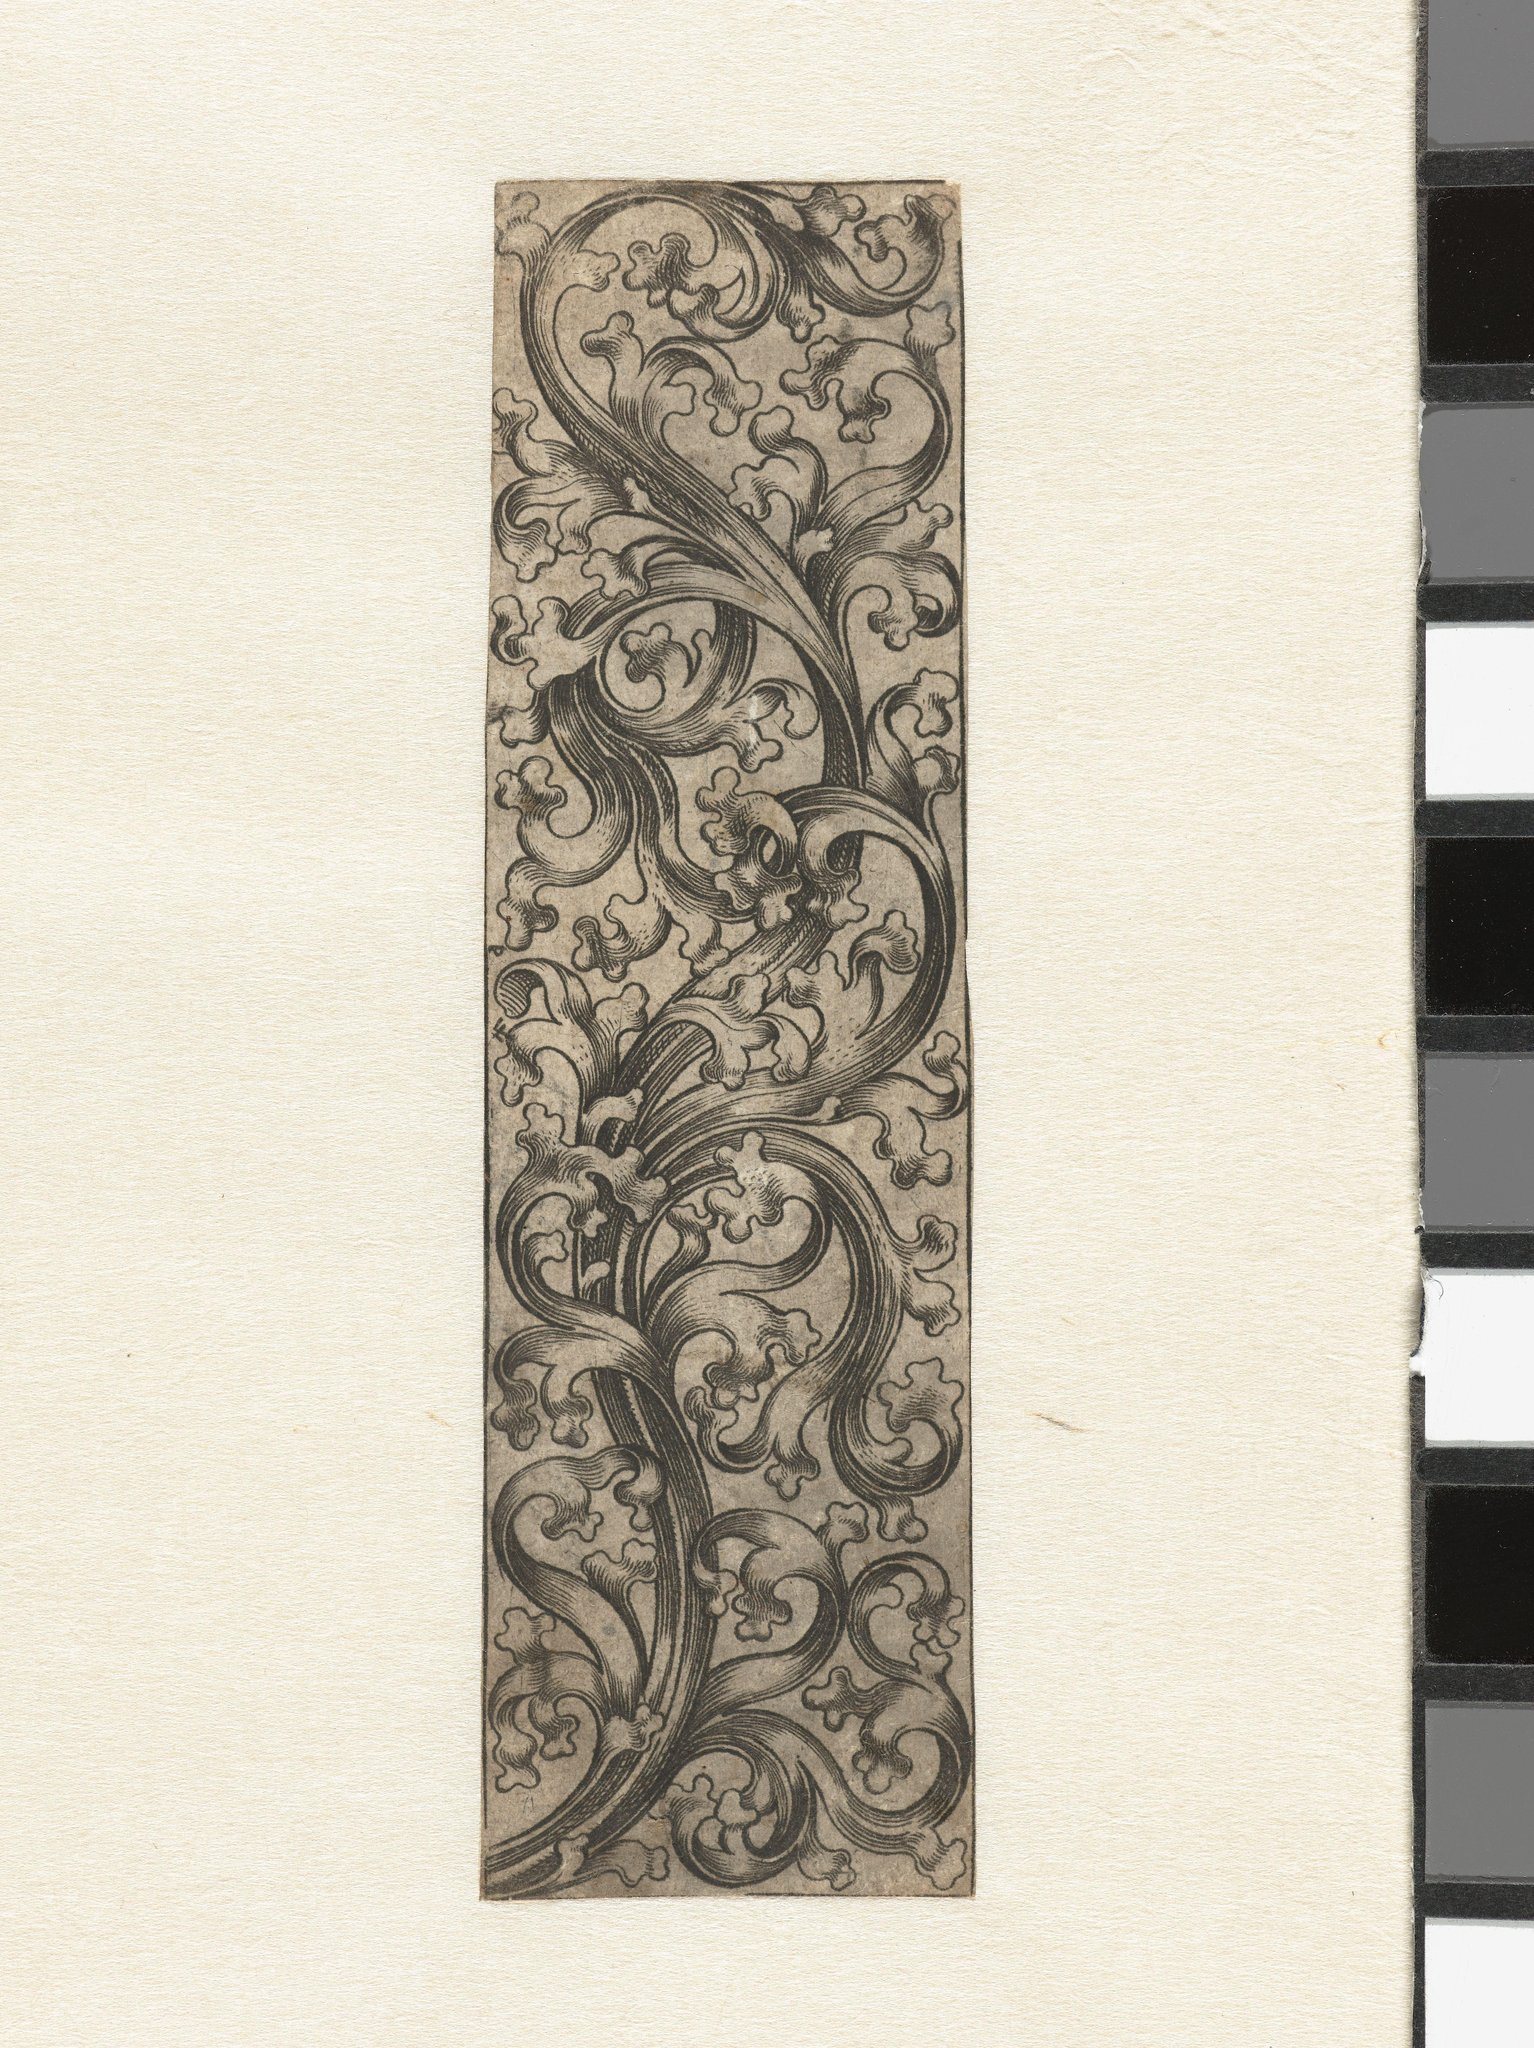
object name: print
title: Fries met bladranken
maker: monogrammist pw van keulen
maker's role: print maker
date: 1470-1500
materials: paper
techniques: engraving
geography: germany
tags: ornament derived from plant forms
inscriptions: collector's mark: Lugt 240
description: Ornament van bladranken die zich met een golvende beweging over het blad verspreiden.